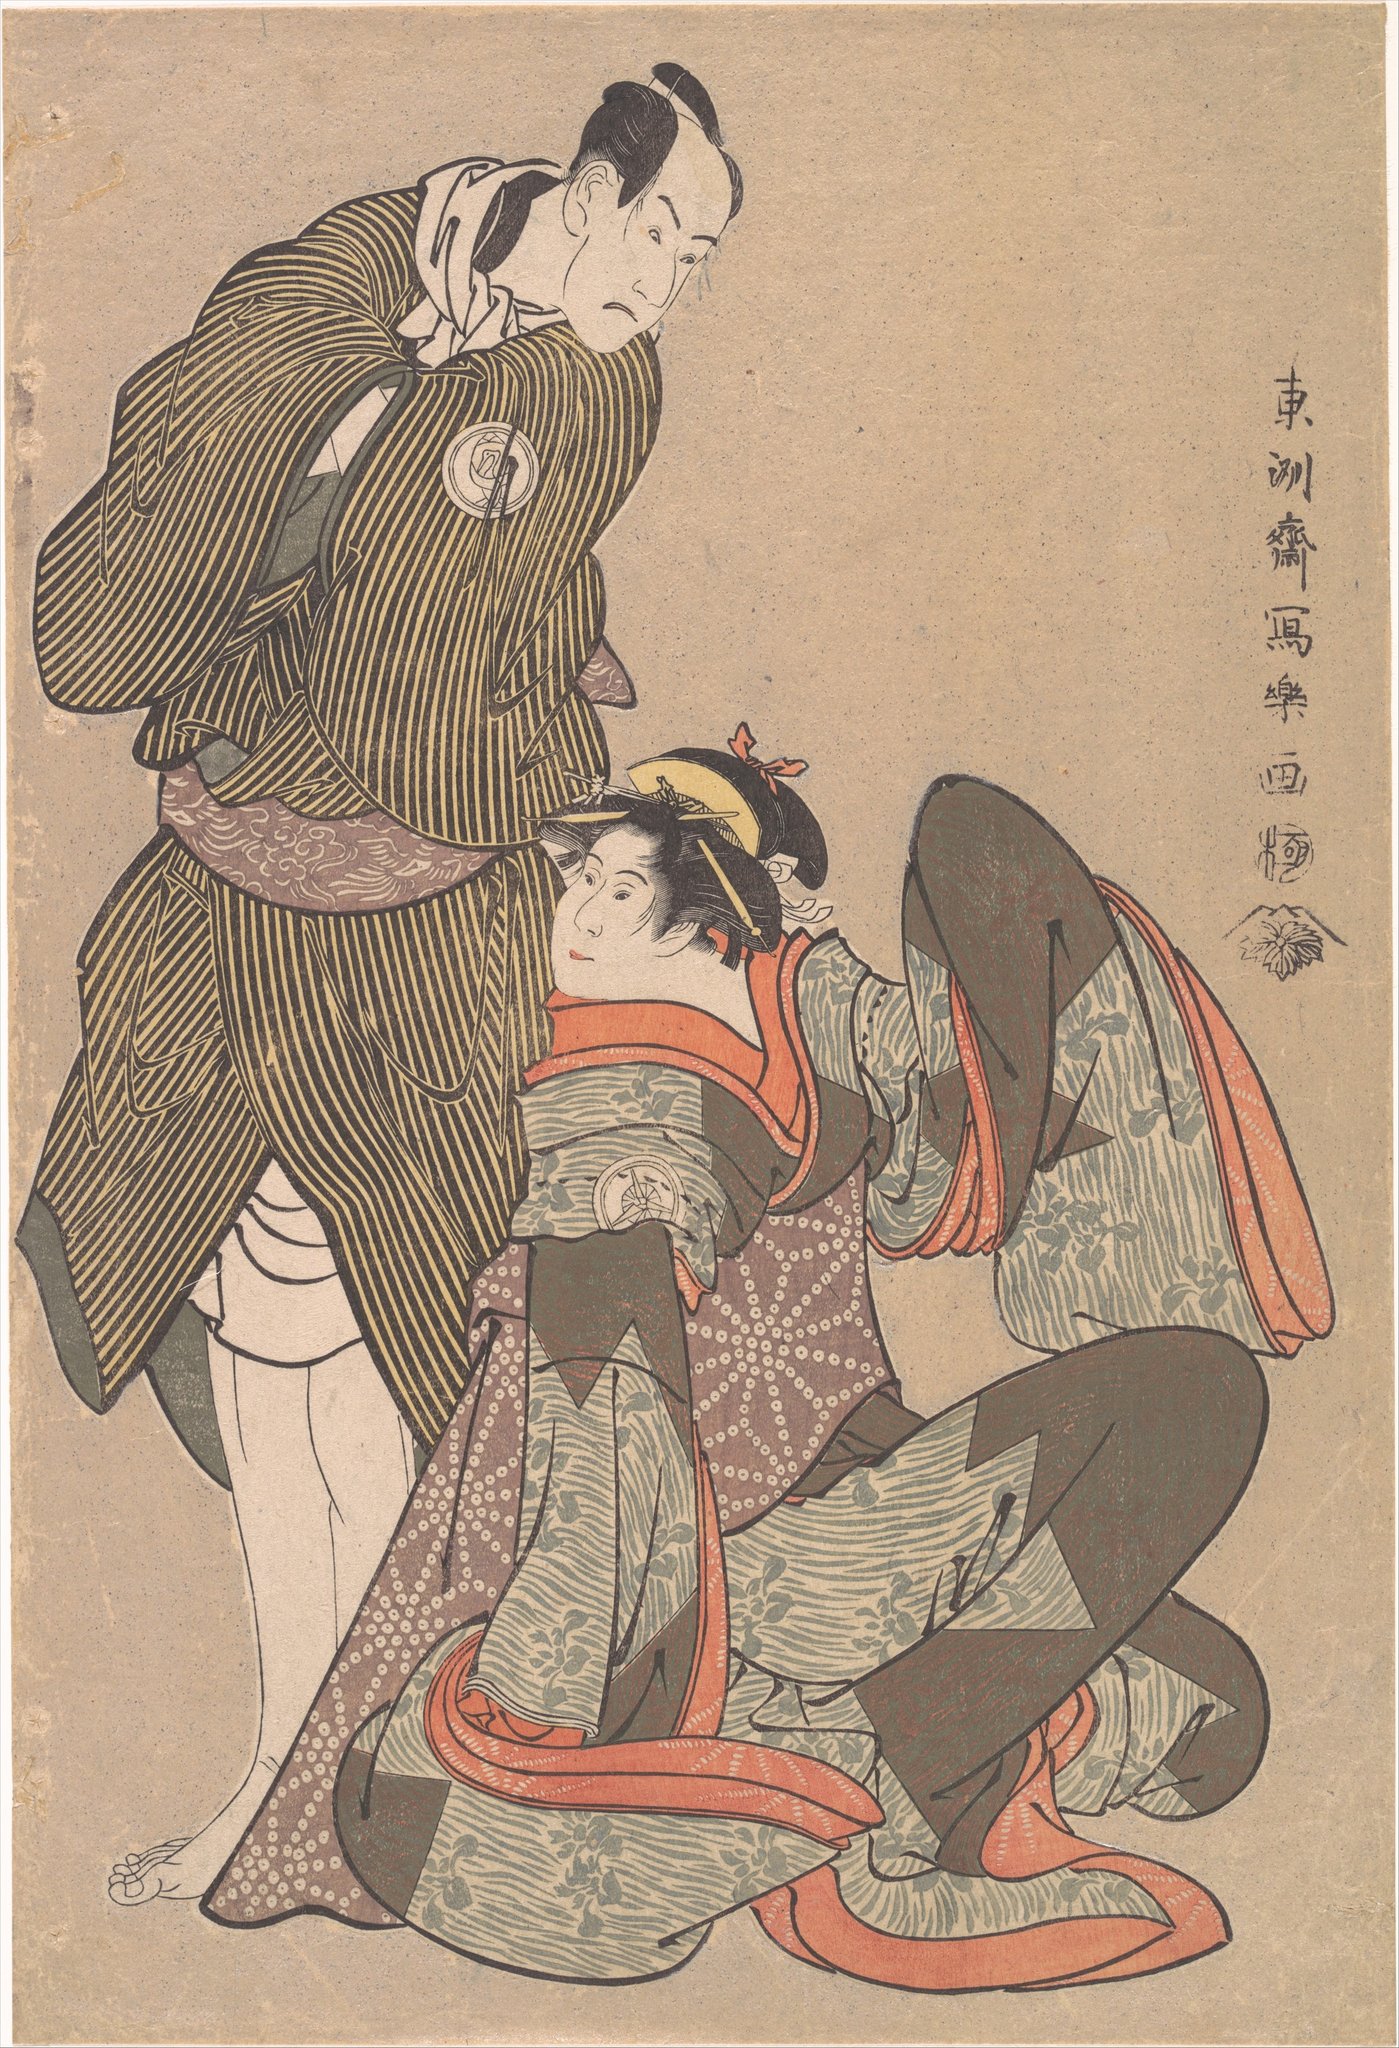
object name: print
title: Bandō Hikosaburō III in the Role of Obiya Chōemon and Iwai Hanshiro IV in the Role of Shinanoya Ohan, from the Play “Nihonmatsu Michinoku sodachi”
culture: japanese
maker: tōshūsai sharaku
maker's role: artist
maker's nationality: japanese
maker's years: 1794-1795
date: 1794-1795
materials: ink, mica, paper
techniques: woodblock print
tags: men,actors